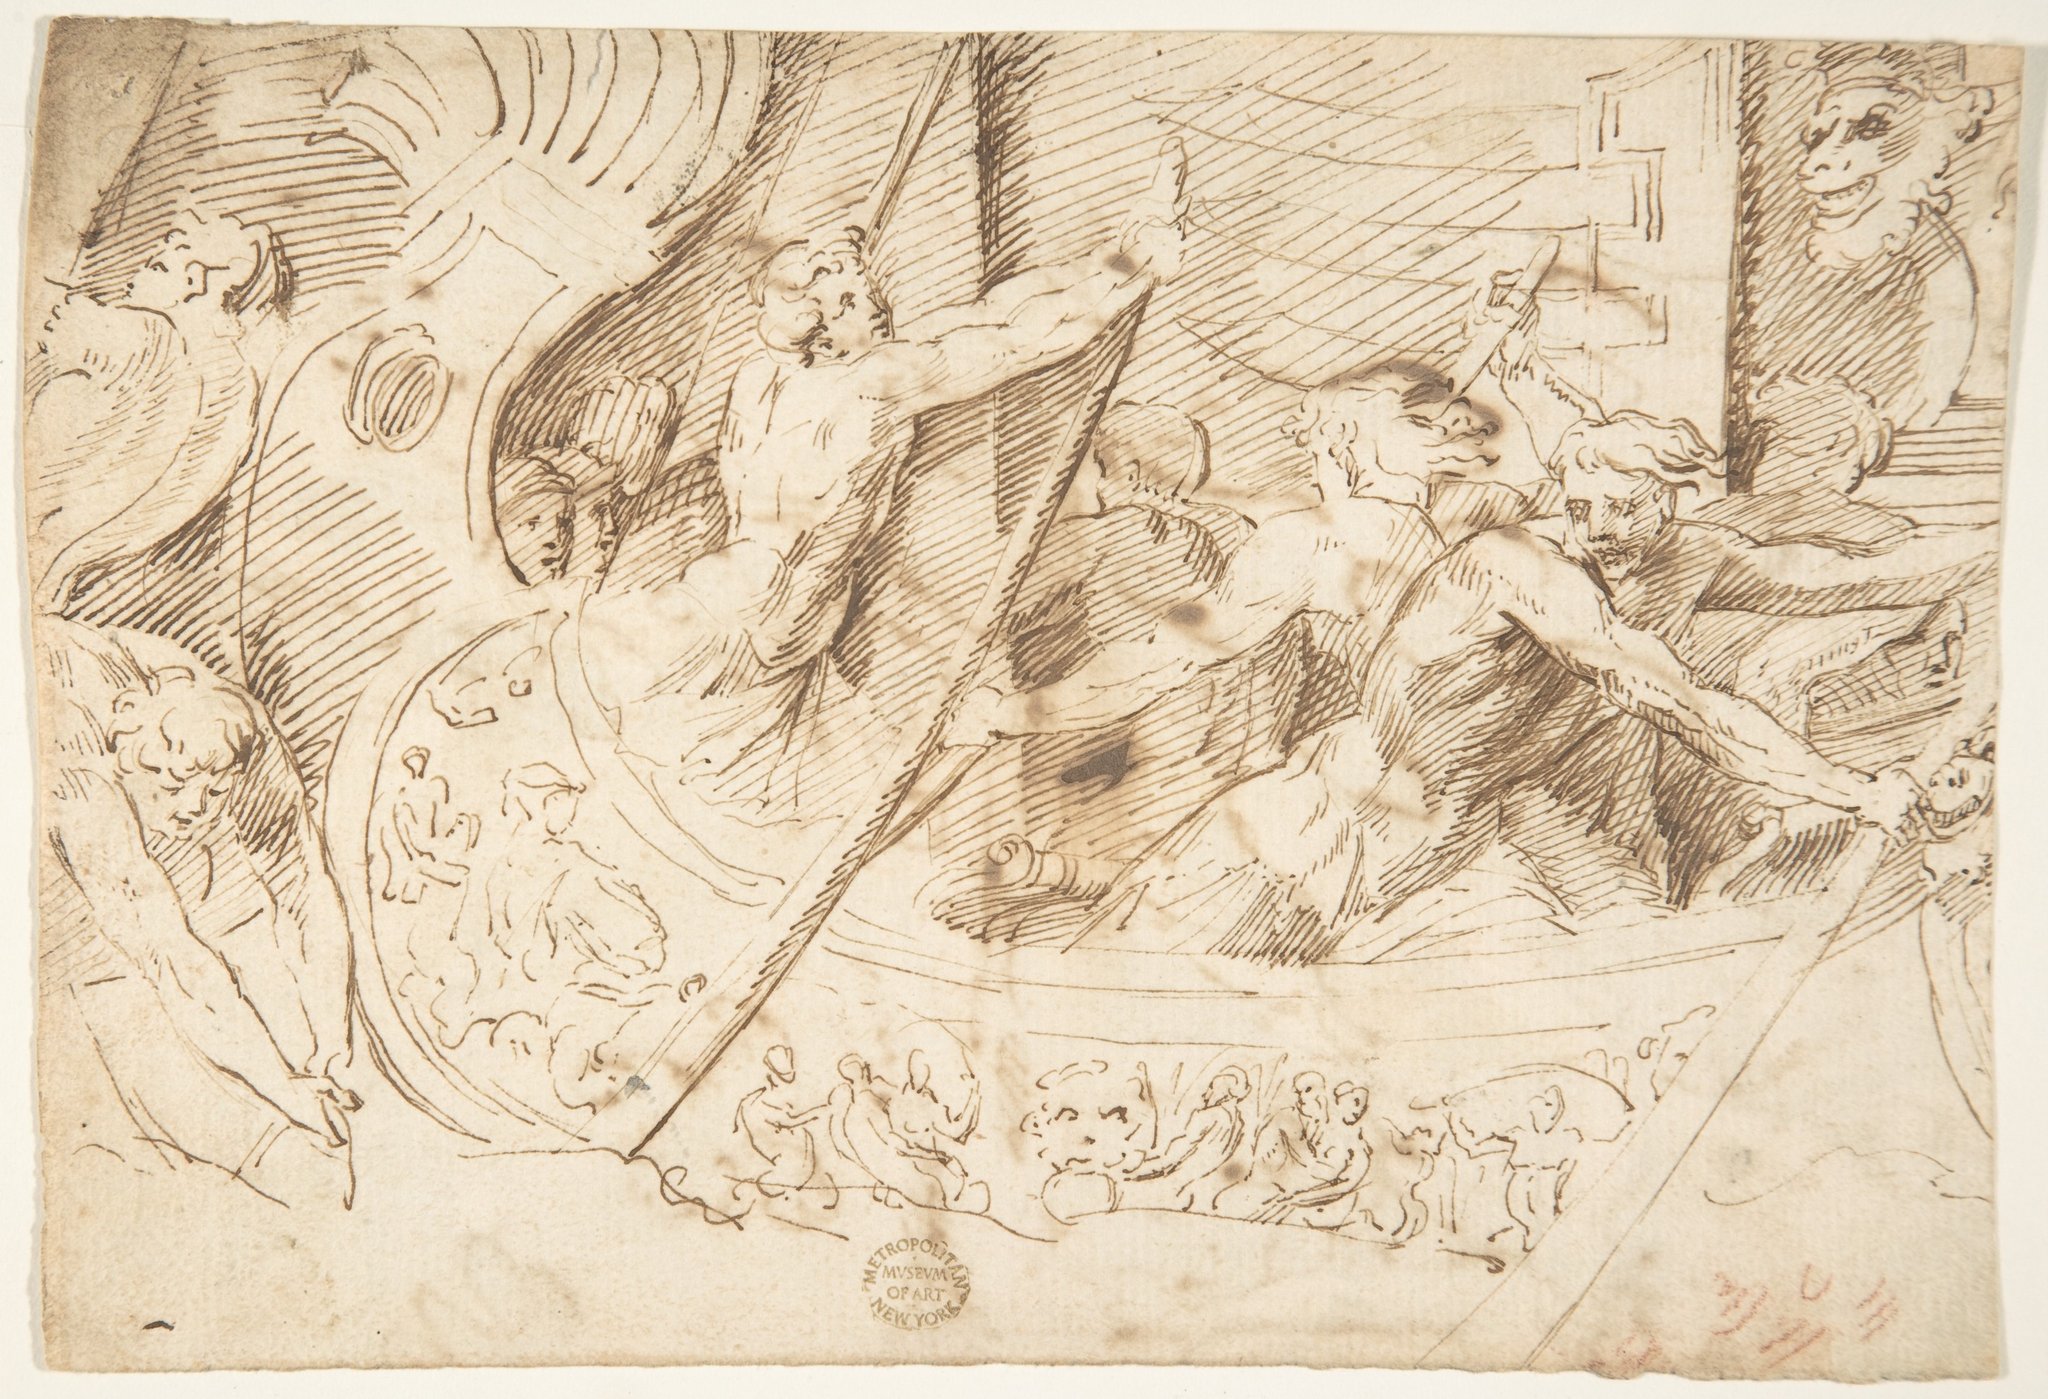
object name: drawing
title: Naval Battle (recto); Forest with Angel (verso)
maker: anonymous, italian, 16th century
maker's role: artist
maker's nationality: italian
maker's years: 1550-1600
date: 1501-1600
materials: ink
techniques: brush, pen, wash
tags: battles,men,angels,boats